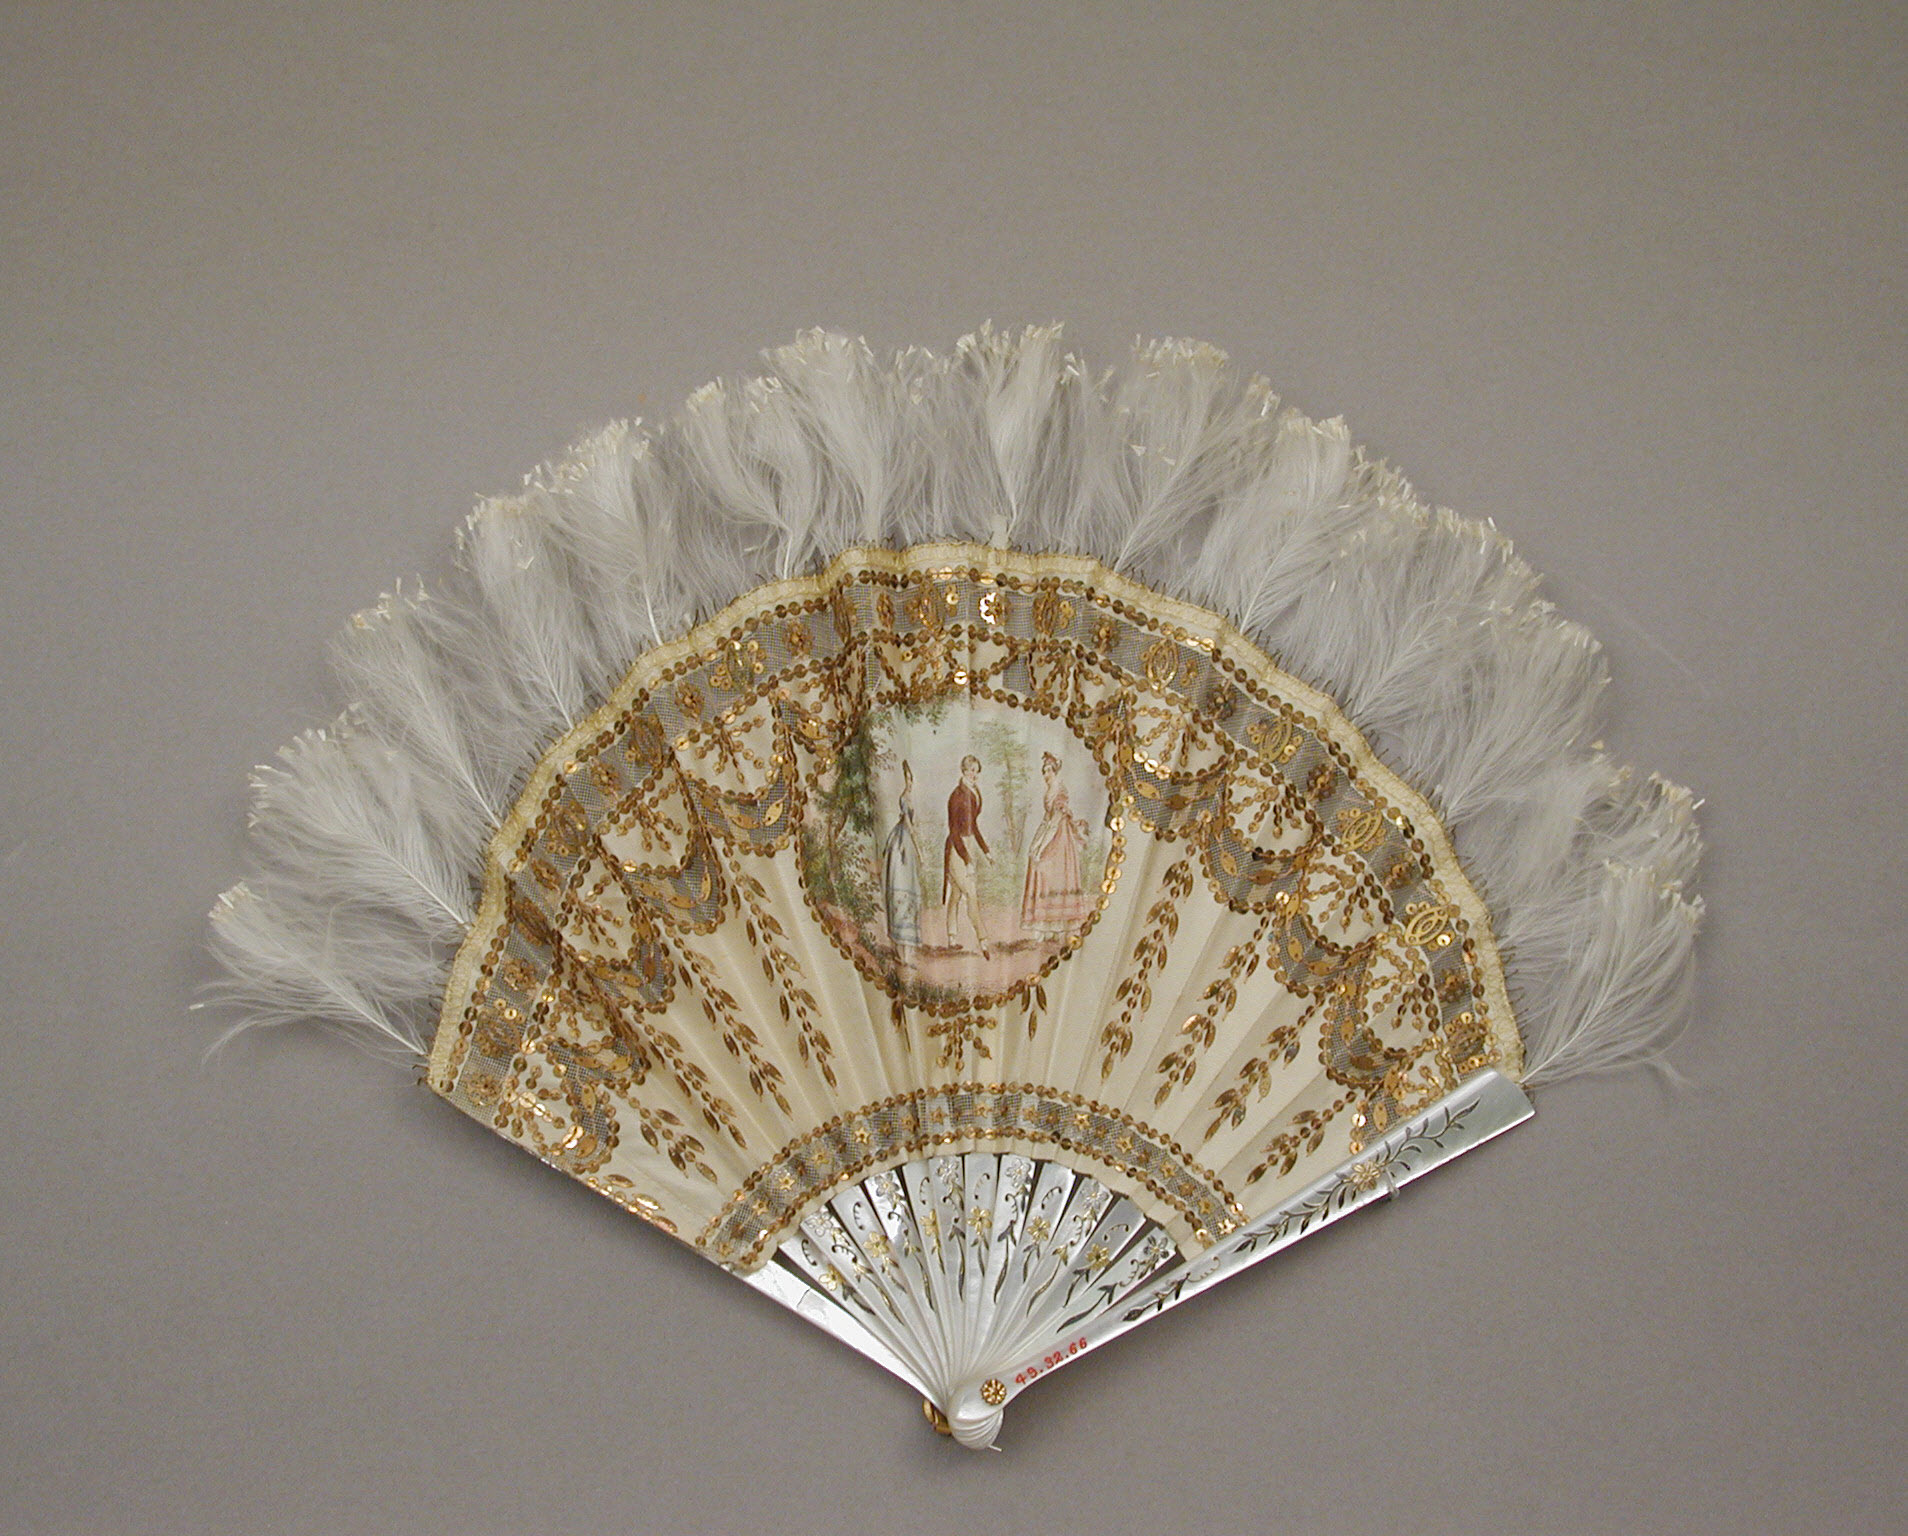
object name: fan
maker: tiffany & co.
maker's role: manufacturer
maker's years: 1837-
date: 1867-1900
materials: brass, feather, metal, mother of pearl, silk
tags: men,women